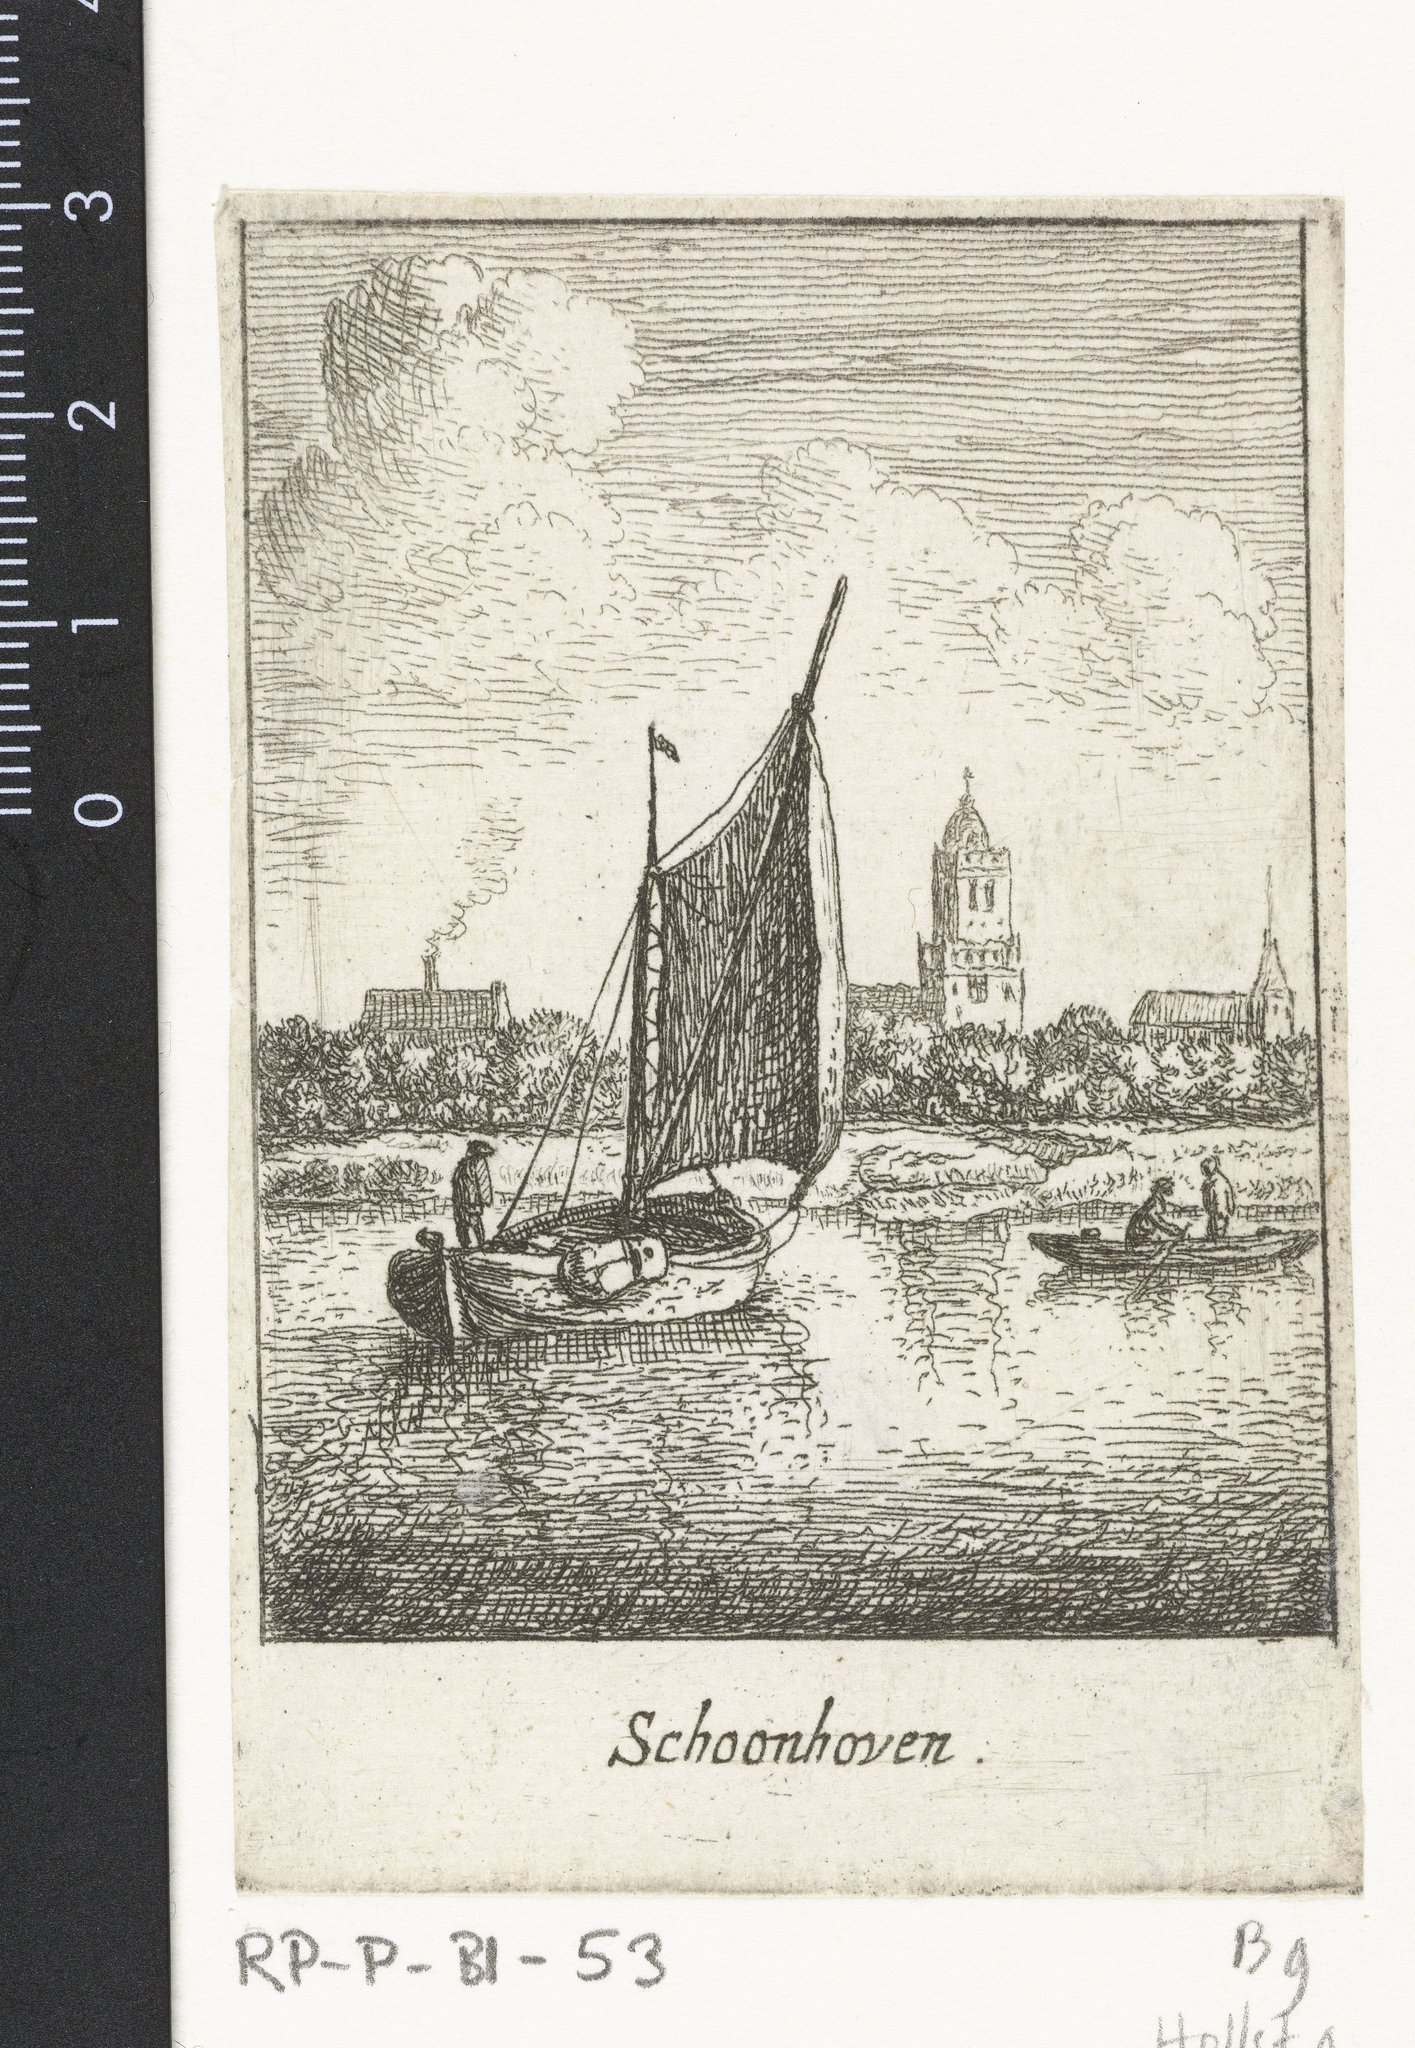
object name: print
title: Nederlandse dorpsgezichten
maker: jan van almeloveen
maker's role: draughtsman, print maker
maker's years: 1652-1683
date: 1662-1683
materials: paper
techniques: etching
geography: netherlands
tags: village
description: Gezicht op Schoonhoven vanuit het water. Prent uit een serie van twaalf dorpsgezichten van Nederlandse plaatsen in de buurt van Utrecht met boten op de voorgrond.